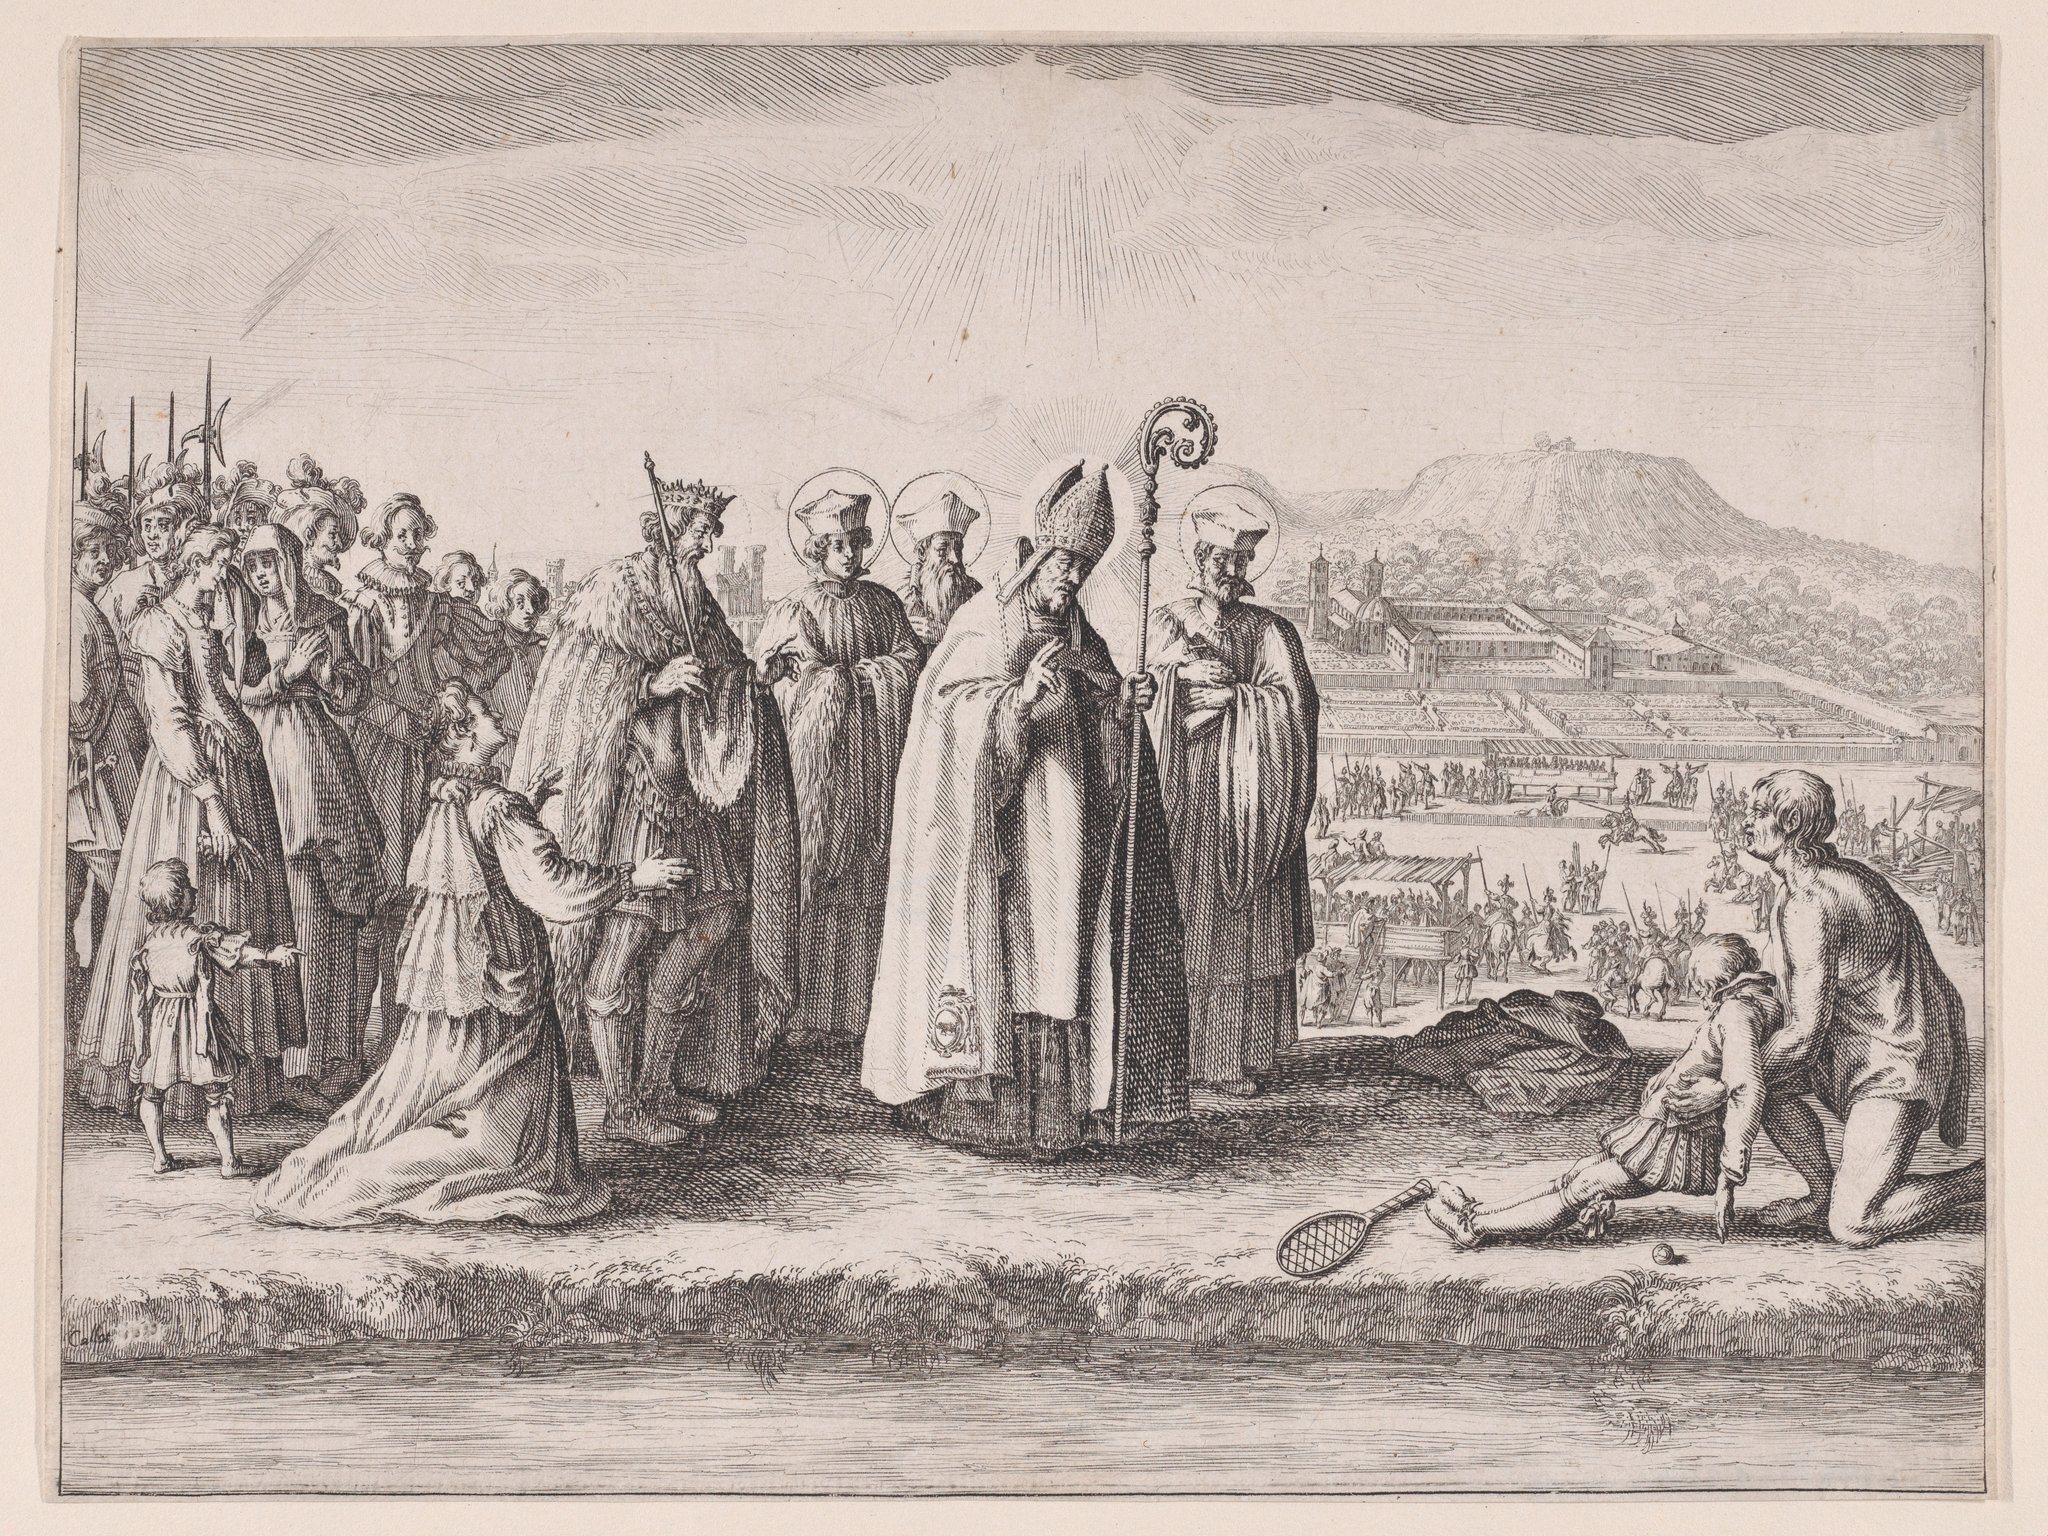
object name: print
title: Saint Mansuy, pièce appelée aussi Saint Mansuet ou La Raquette (Saint Mansuy, piece also called Saint Mansuet or The Racket)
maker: jacques callot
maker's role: artist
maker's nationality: french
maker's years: 1592-1635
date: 1616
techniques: etching